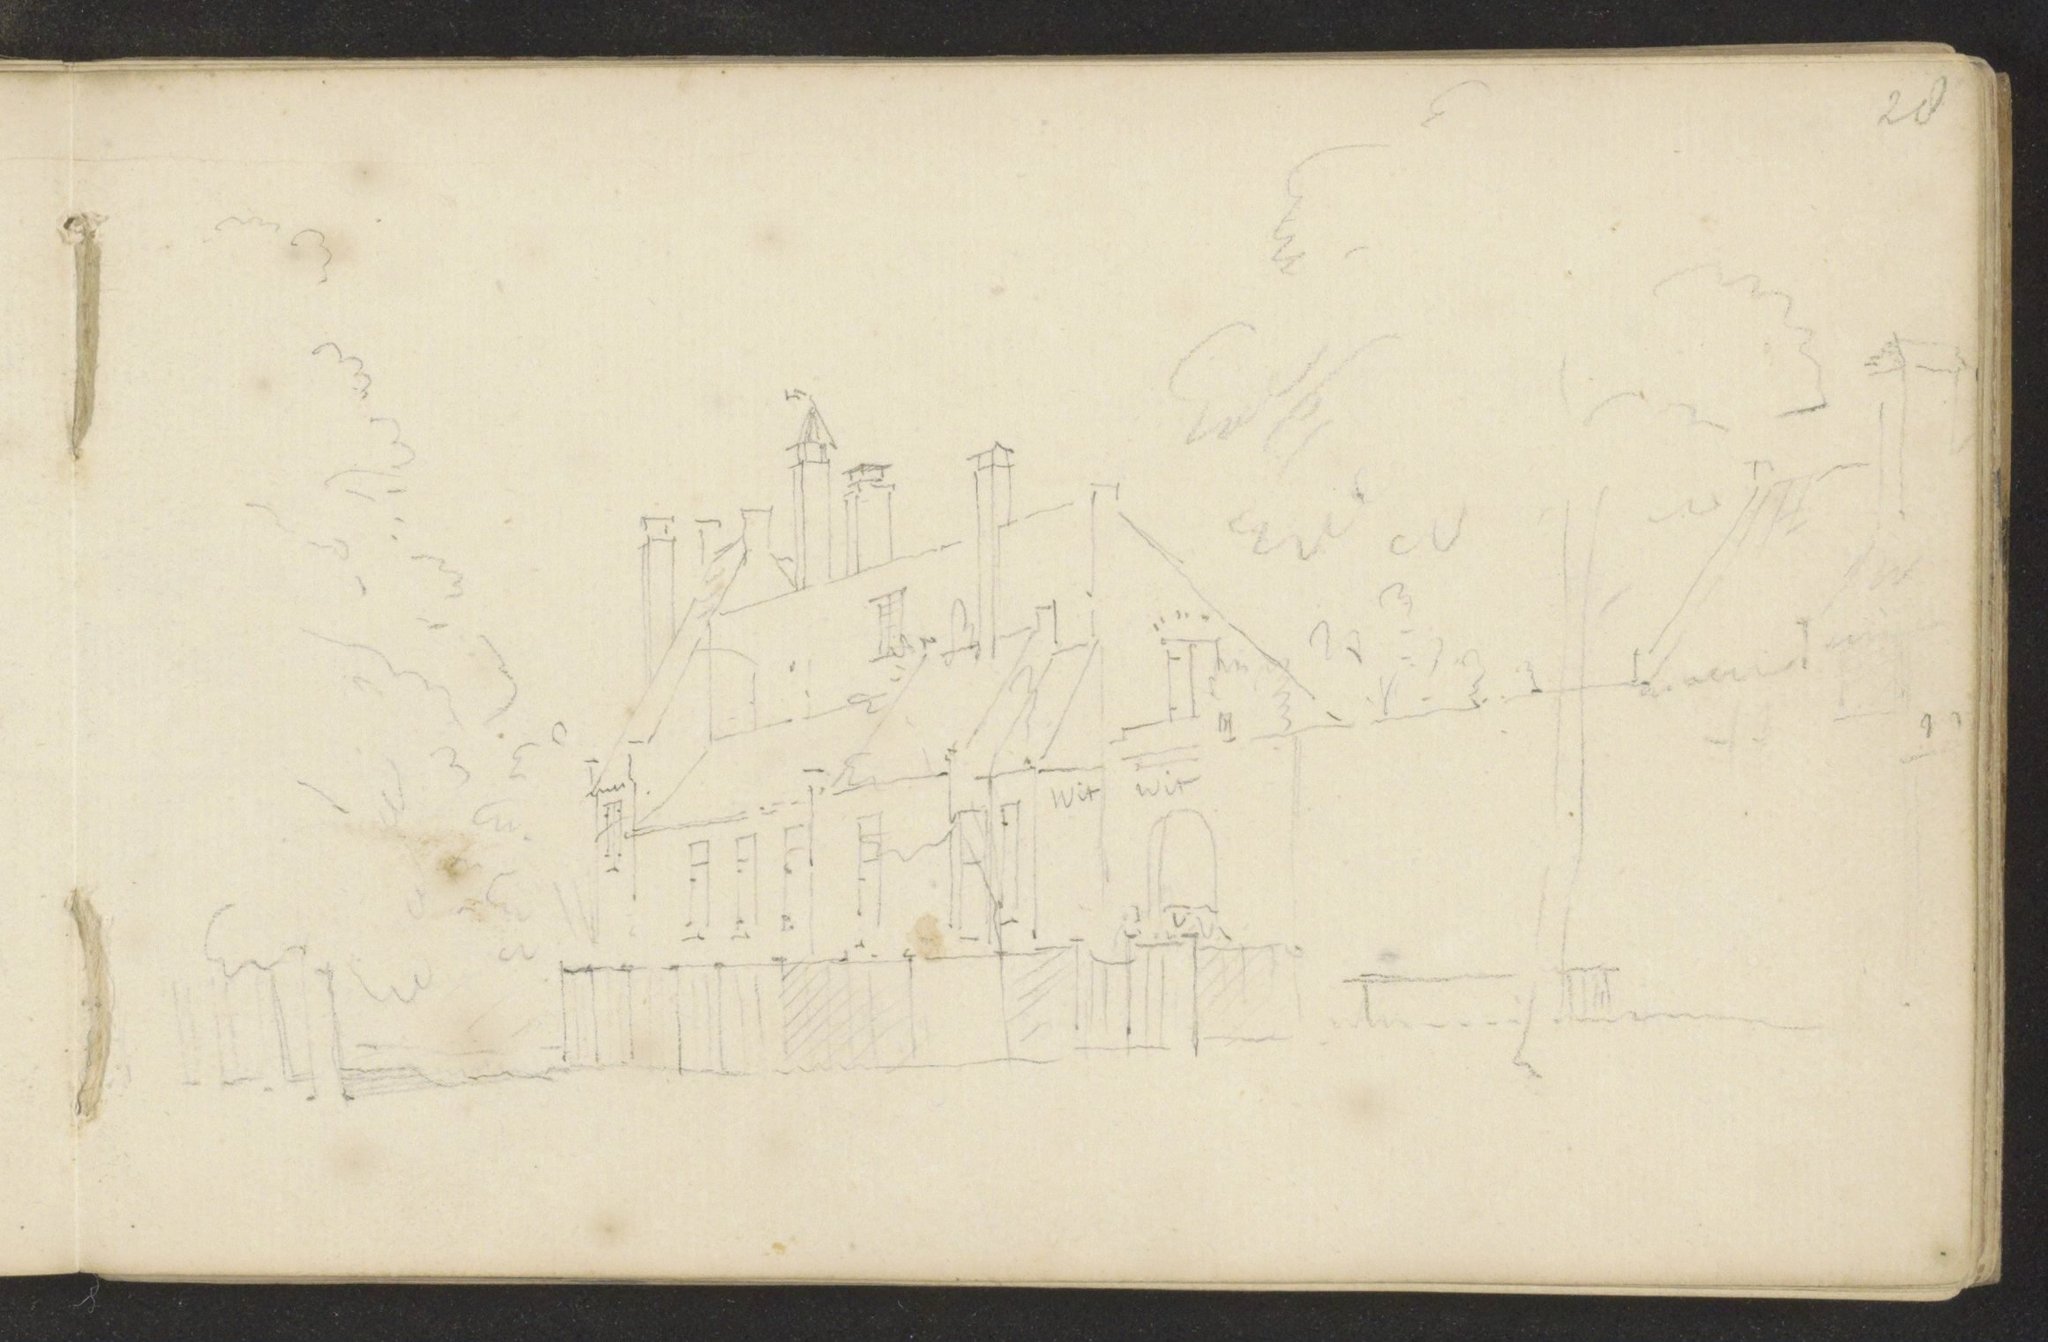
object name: sketchbook leaf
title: Het Hof te Rijnsburg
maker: abraham de haen (ii)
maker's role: draughtsman, print maker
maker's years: 1707-1748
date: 1731-1732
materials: paper, pencil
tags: country-house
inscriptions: kleurnotitie, handgeschreven in potlood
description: Blad 28 recto uit een schetsboek met 78 bladen.